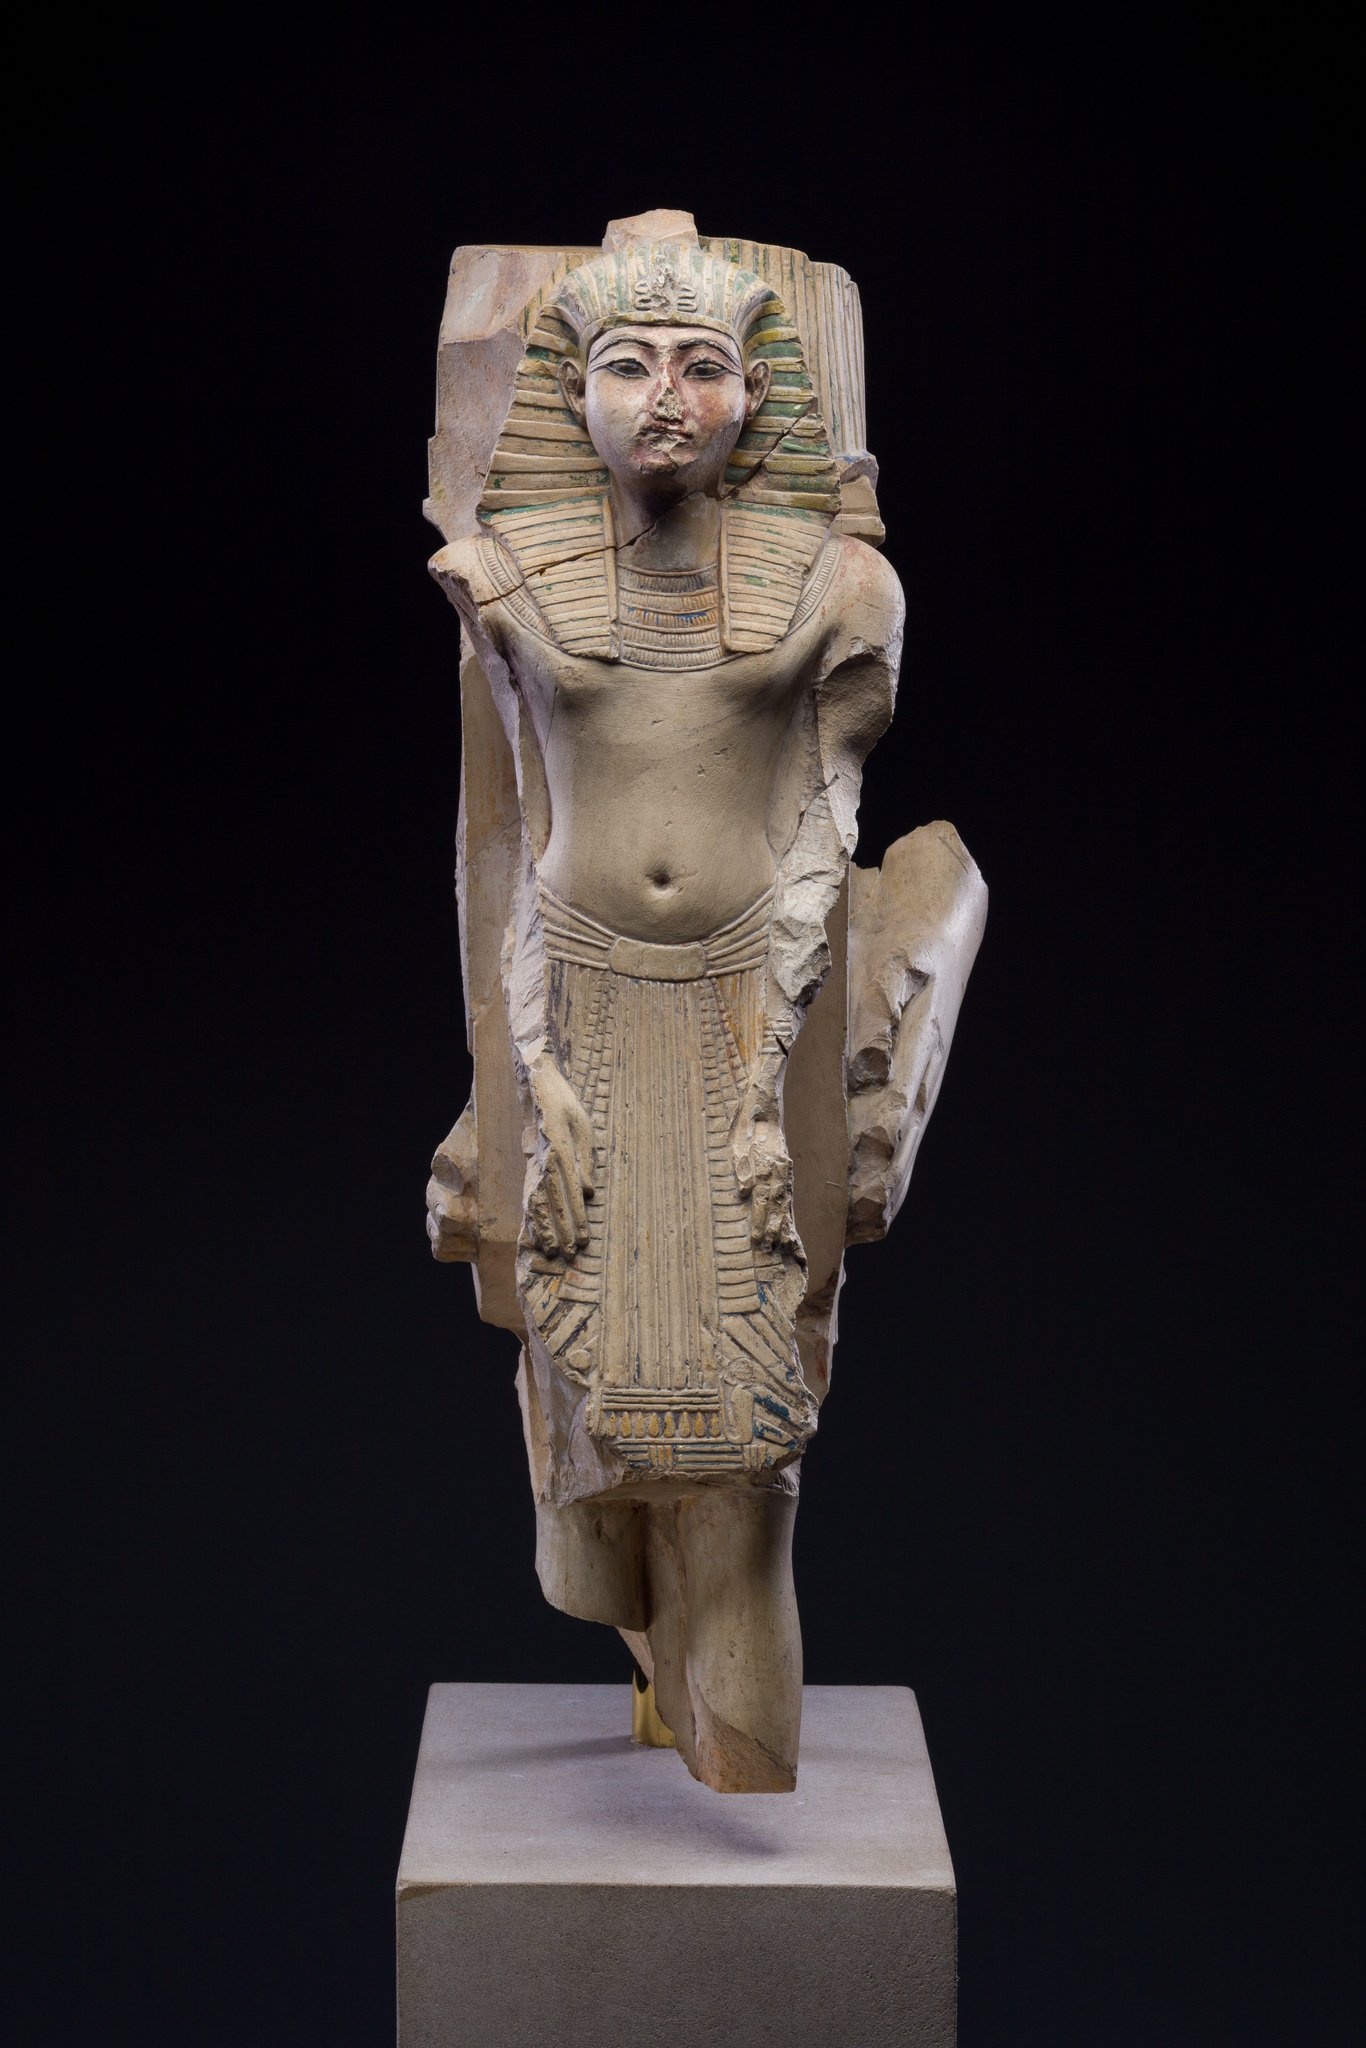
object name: statue, king, official, ramesses ii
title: Figure of a king as part of a group proffered by an official of Ramesses II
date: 1279-1213 BCE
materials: limestone, paint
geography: upper egypt, thebes